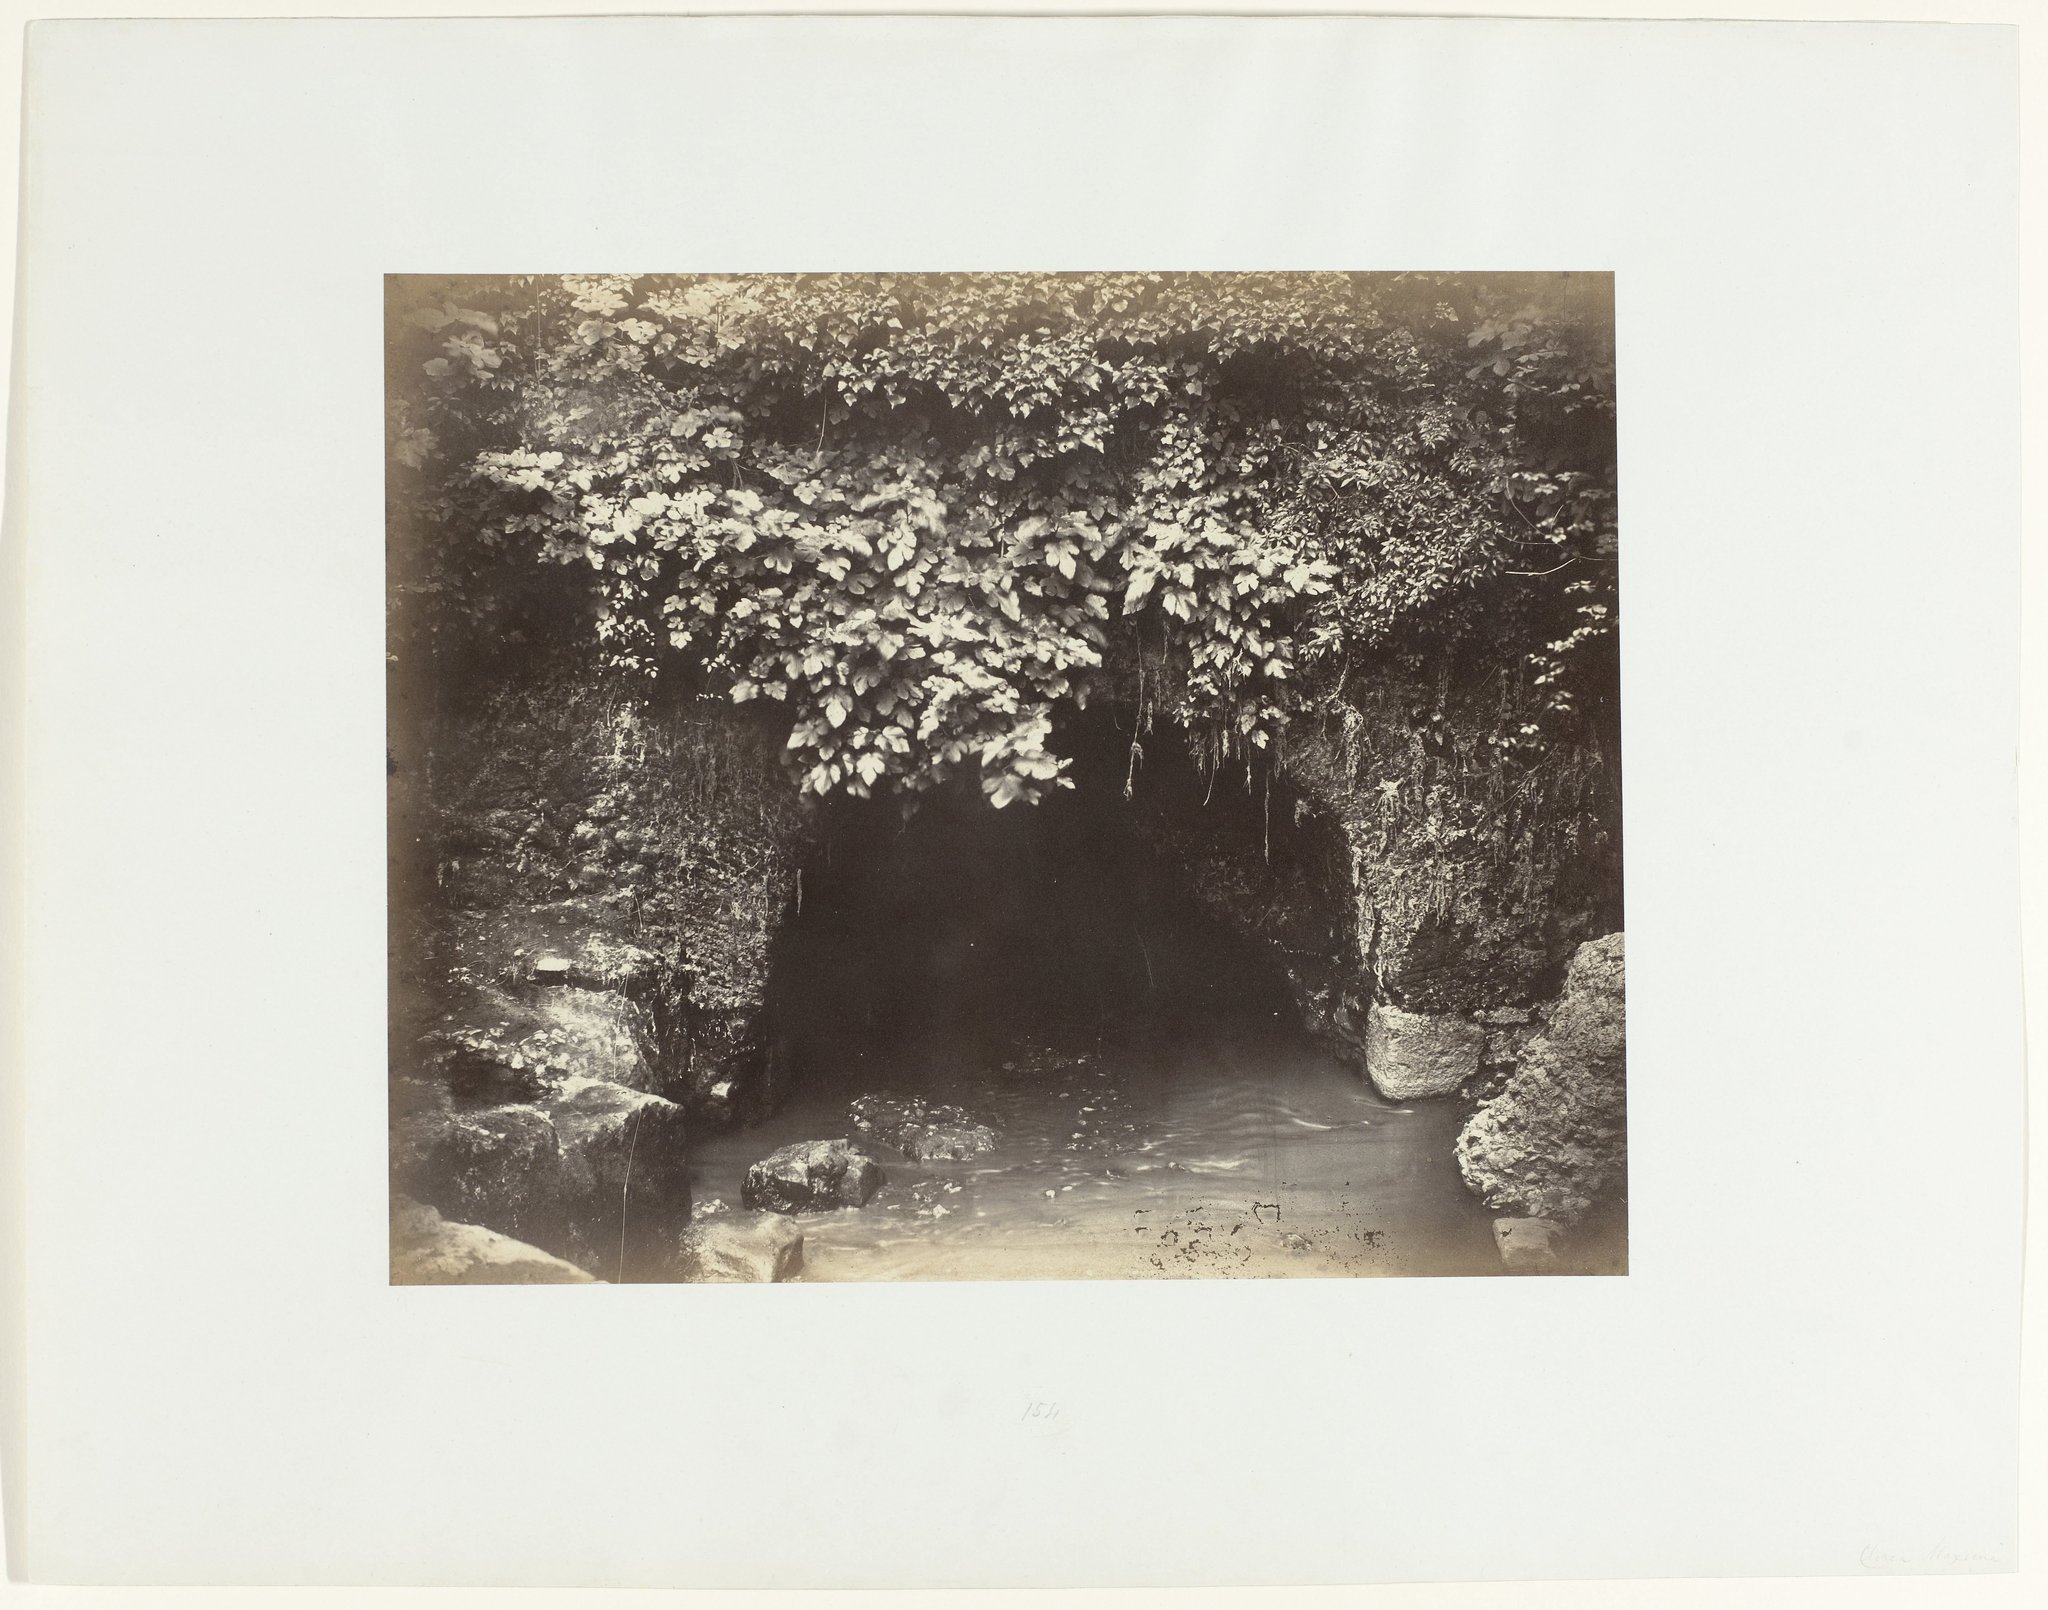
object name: photograph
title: Opening van de Cloaca Maxima, Rome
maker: robert macpherson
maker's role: fotograaf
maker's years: 1814-1872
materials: cardboard, paper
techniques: albumen print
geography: rome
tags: sewers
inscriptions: check stamp: ‘R. Macpherson/ Rome’, number: ‘154’